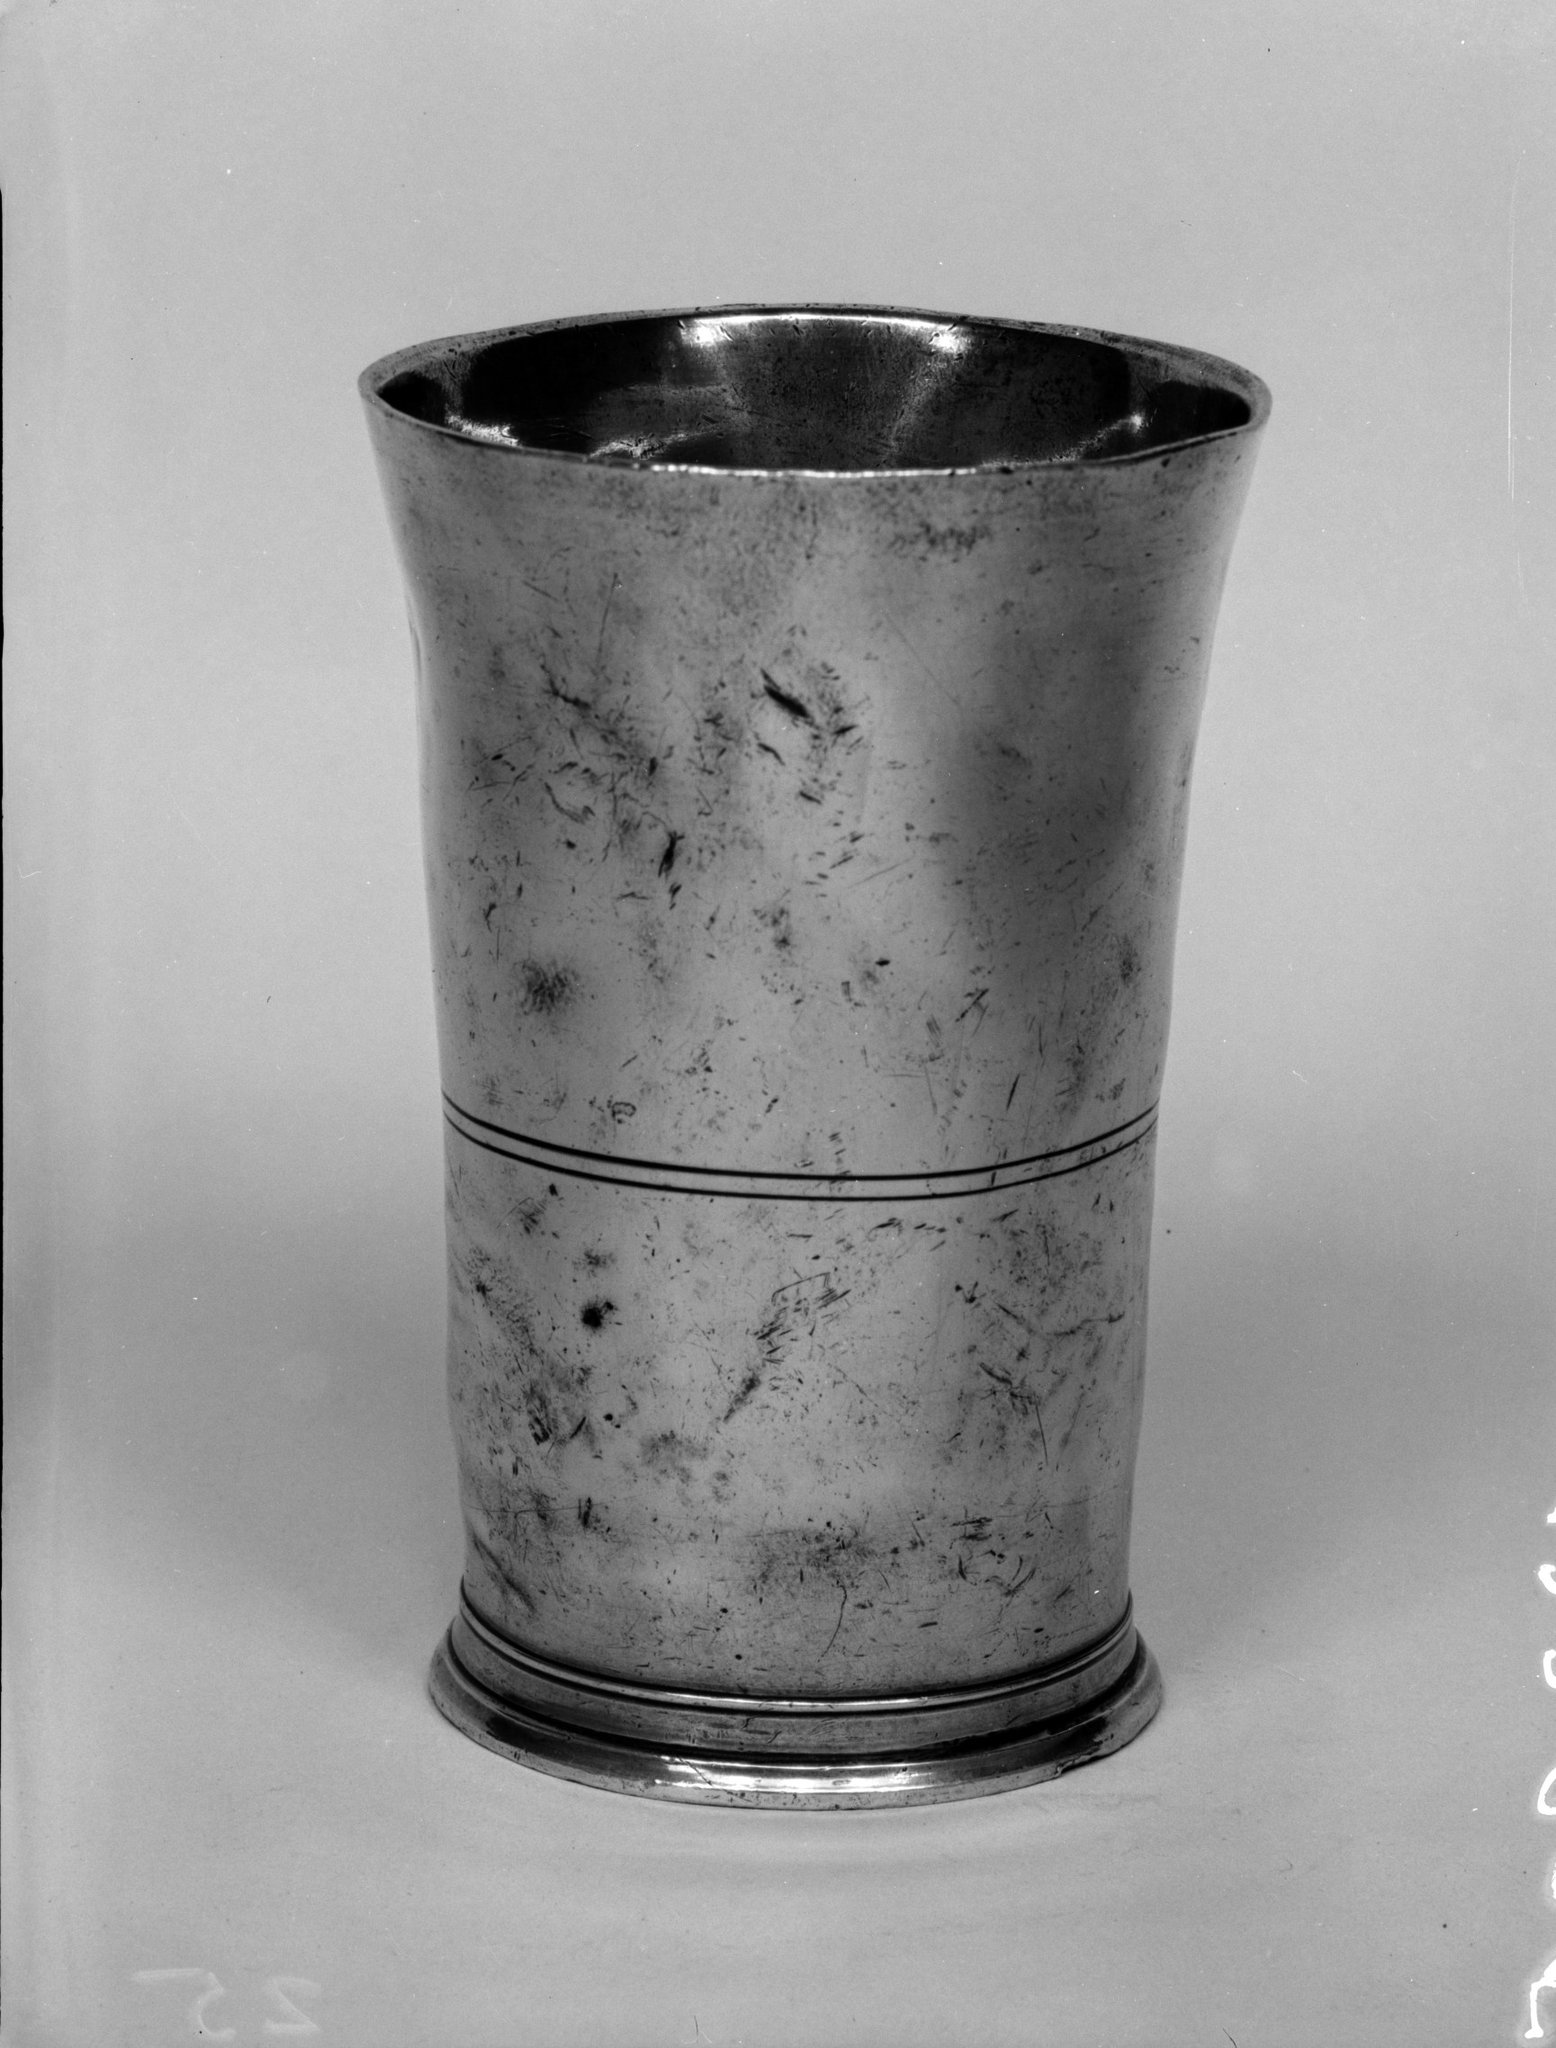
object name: beaker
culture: american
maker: thomas danforth boardman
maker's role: maker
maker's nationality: american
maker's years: 1784-1873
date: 1822-1824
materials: pewter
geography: united states